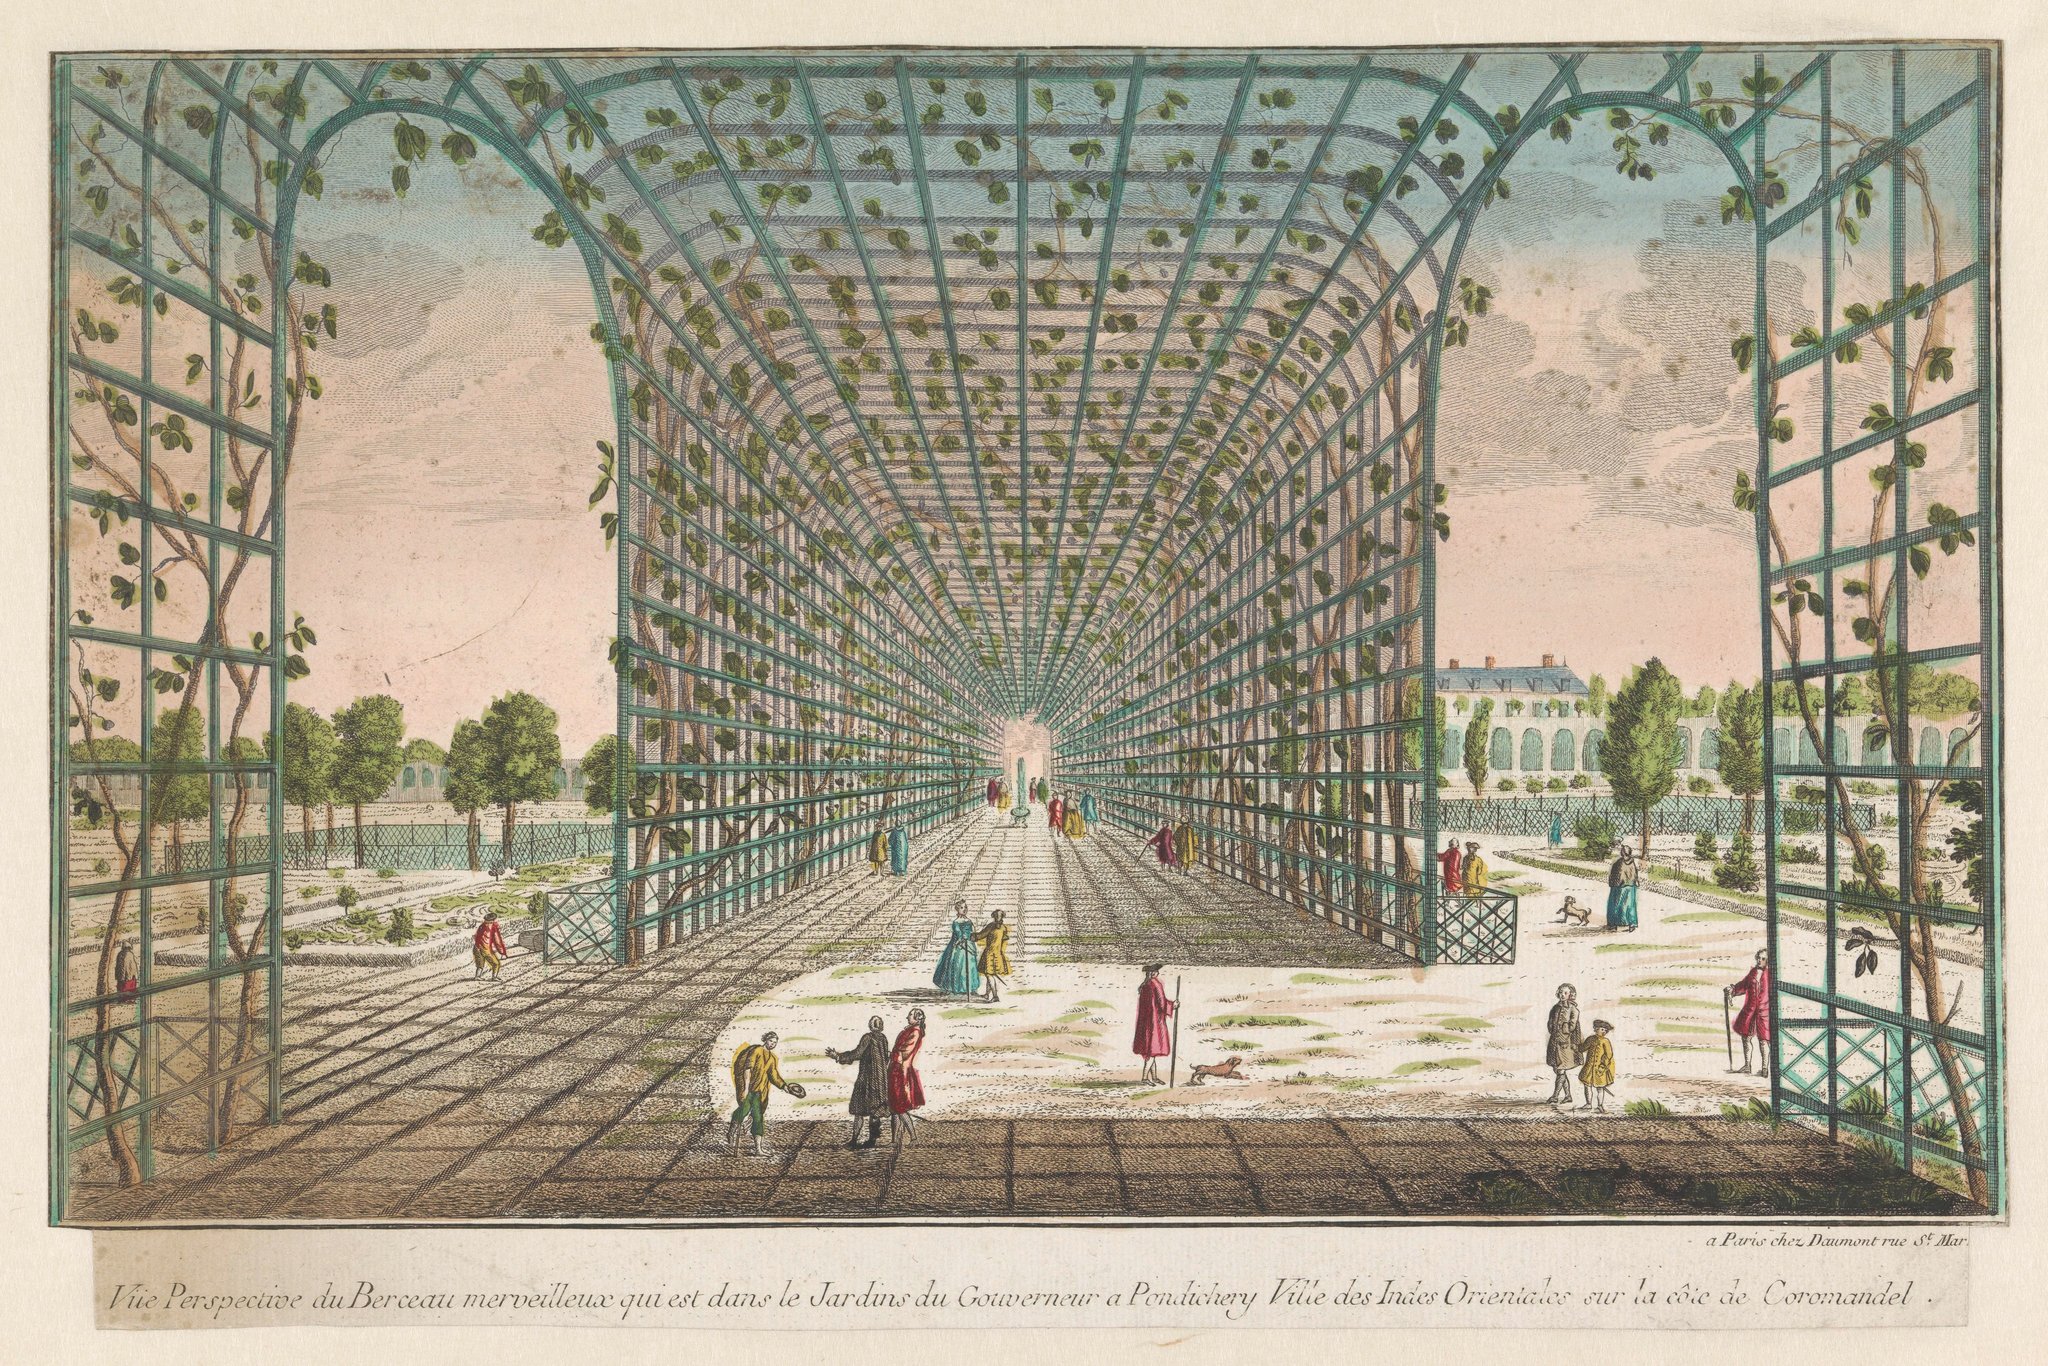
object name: print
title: Gezicht op de loofgang van de tuin van de gouverneur te Pondicherry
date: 1745-1775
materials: paper, watercolor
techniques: brush, etching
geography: paris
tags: garden, garden fountain, ornamental plants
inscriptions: watermark, collector's mark: Lugt 2233